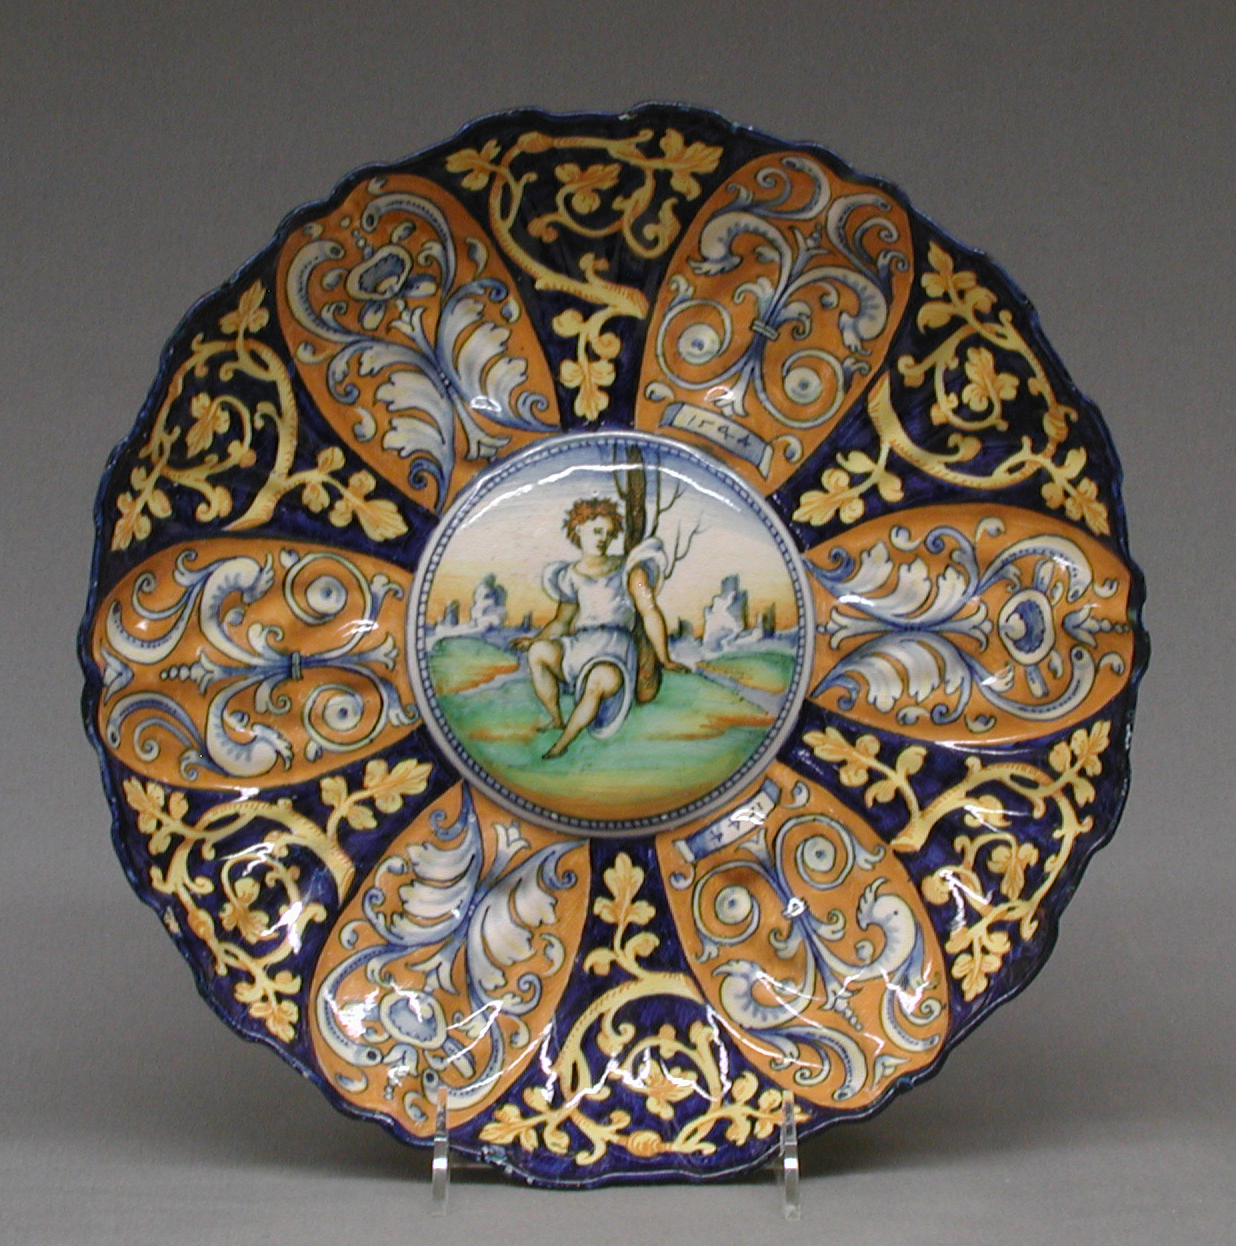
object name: dish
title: Dish (Tazza)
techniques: maiolica, glazing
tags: women